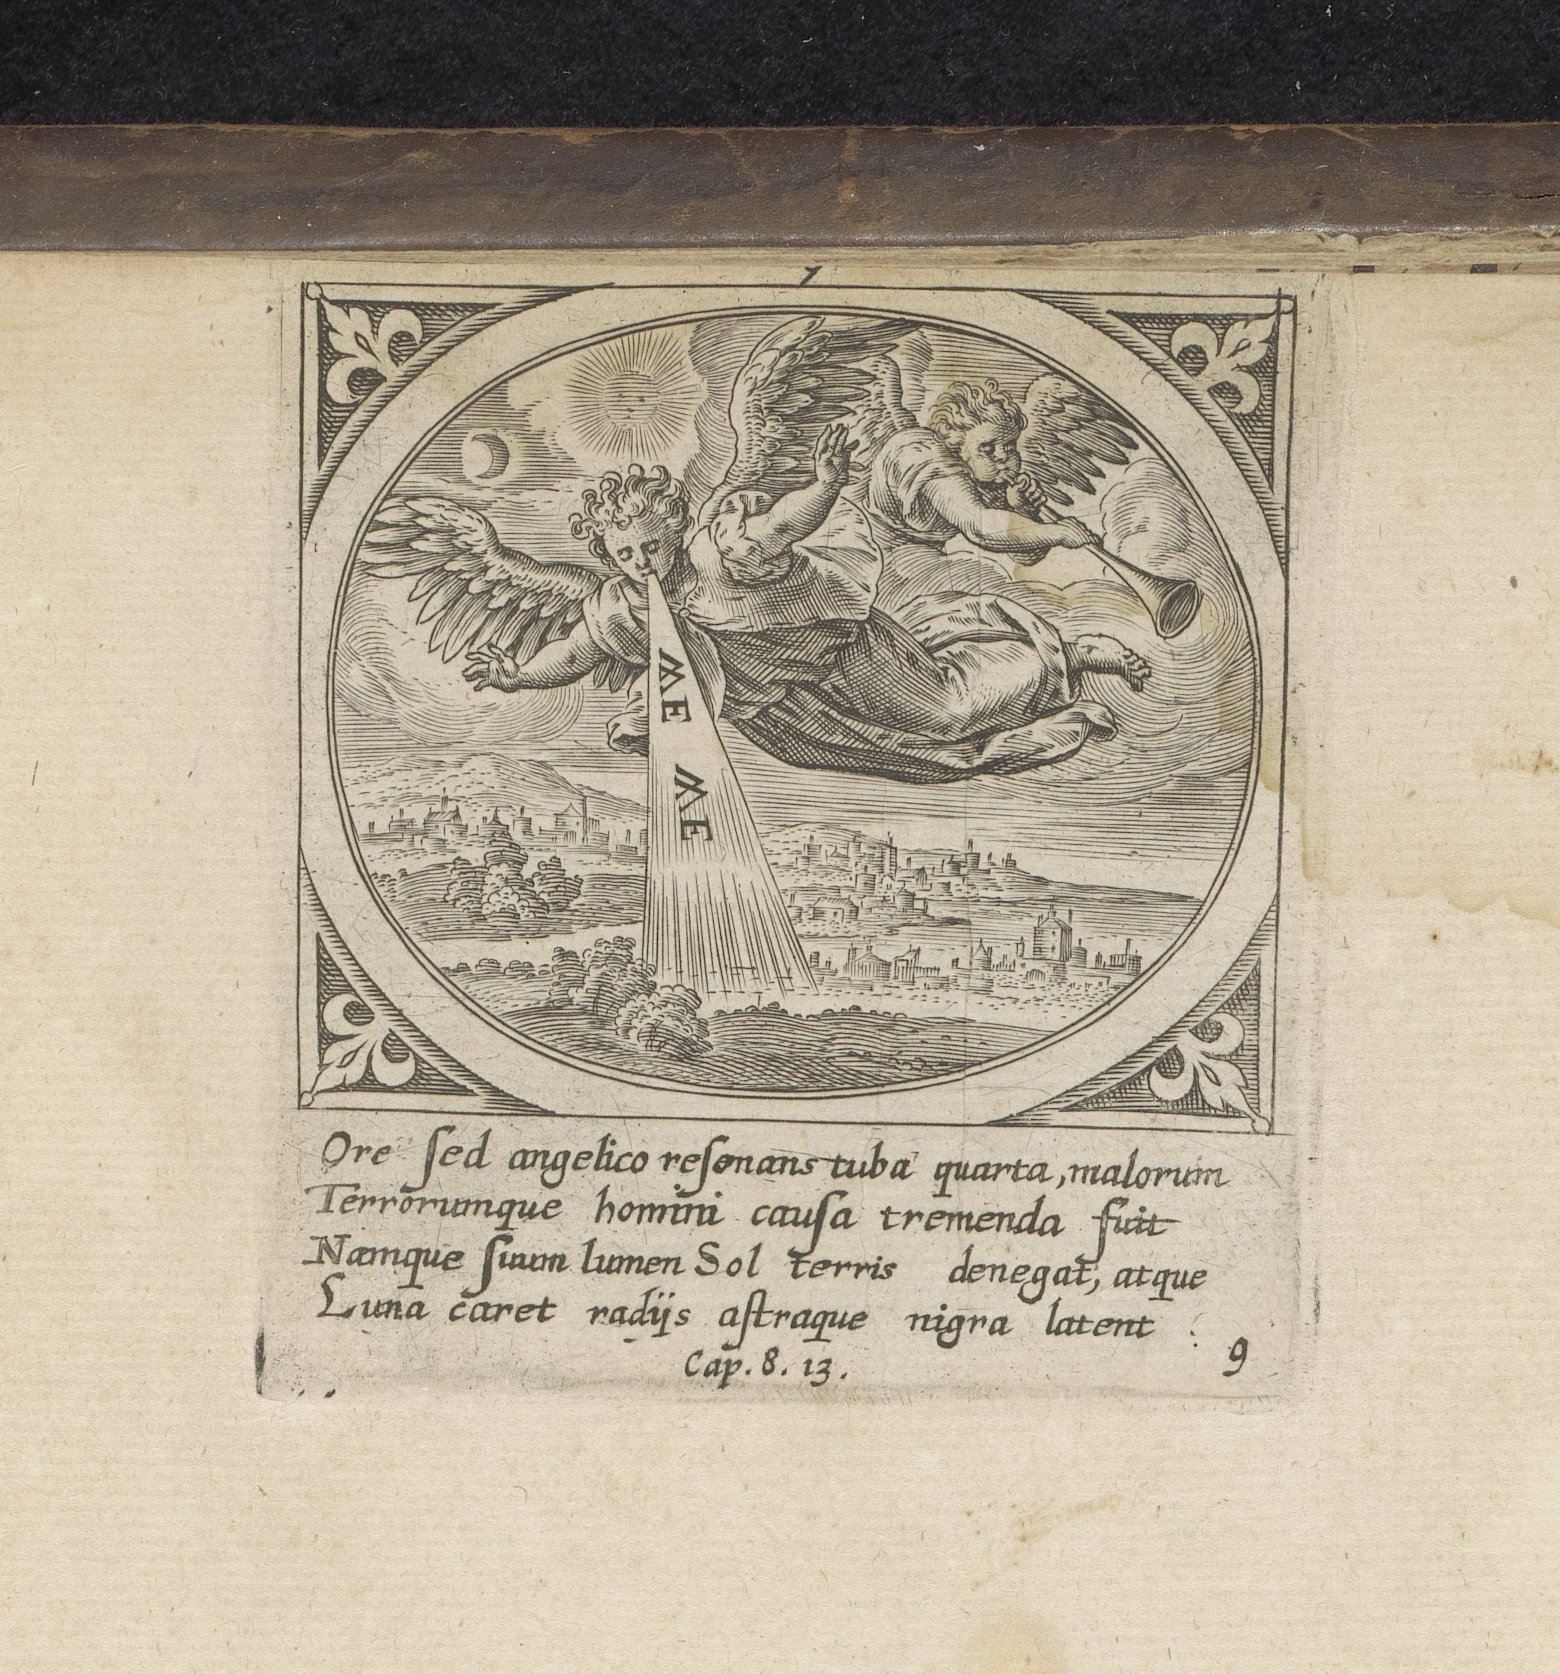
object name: print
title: Den Grooten Figuer-Bibel (...)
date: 1585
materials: paper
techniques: engraving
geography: alkmaar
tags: an angel (or eagle) crying the three woes ~ the seven angels with trumpets, the fourth of the seven angels sounds the trumpet: the sun, the moon and the stars are partially darkened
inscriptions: number: ‘209’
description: De vierde engel blaast op de bazuin en veroorzaakt duisternis op aarde. Een andere engel roept: ‘Wee! Wee!’. Onder de voorstelling een verwijzing in het Latijn naar de Bijbeltekst in Op. 8:13. Deze prent maakt deel uit van een album.